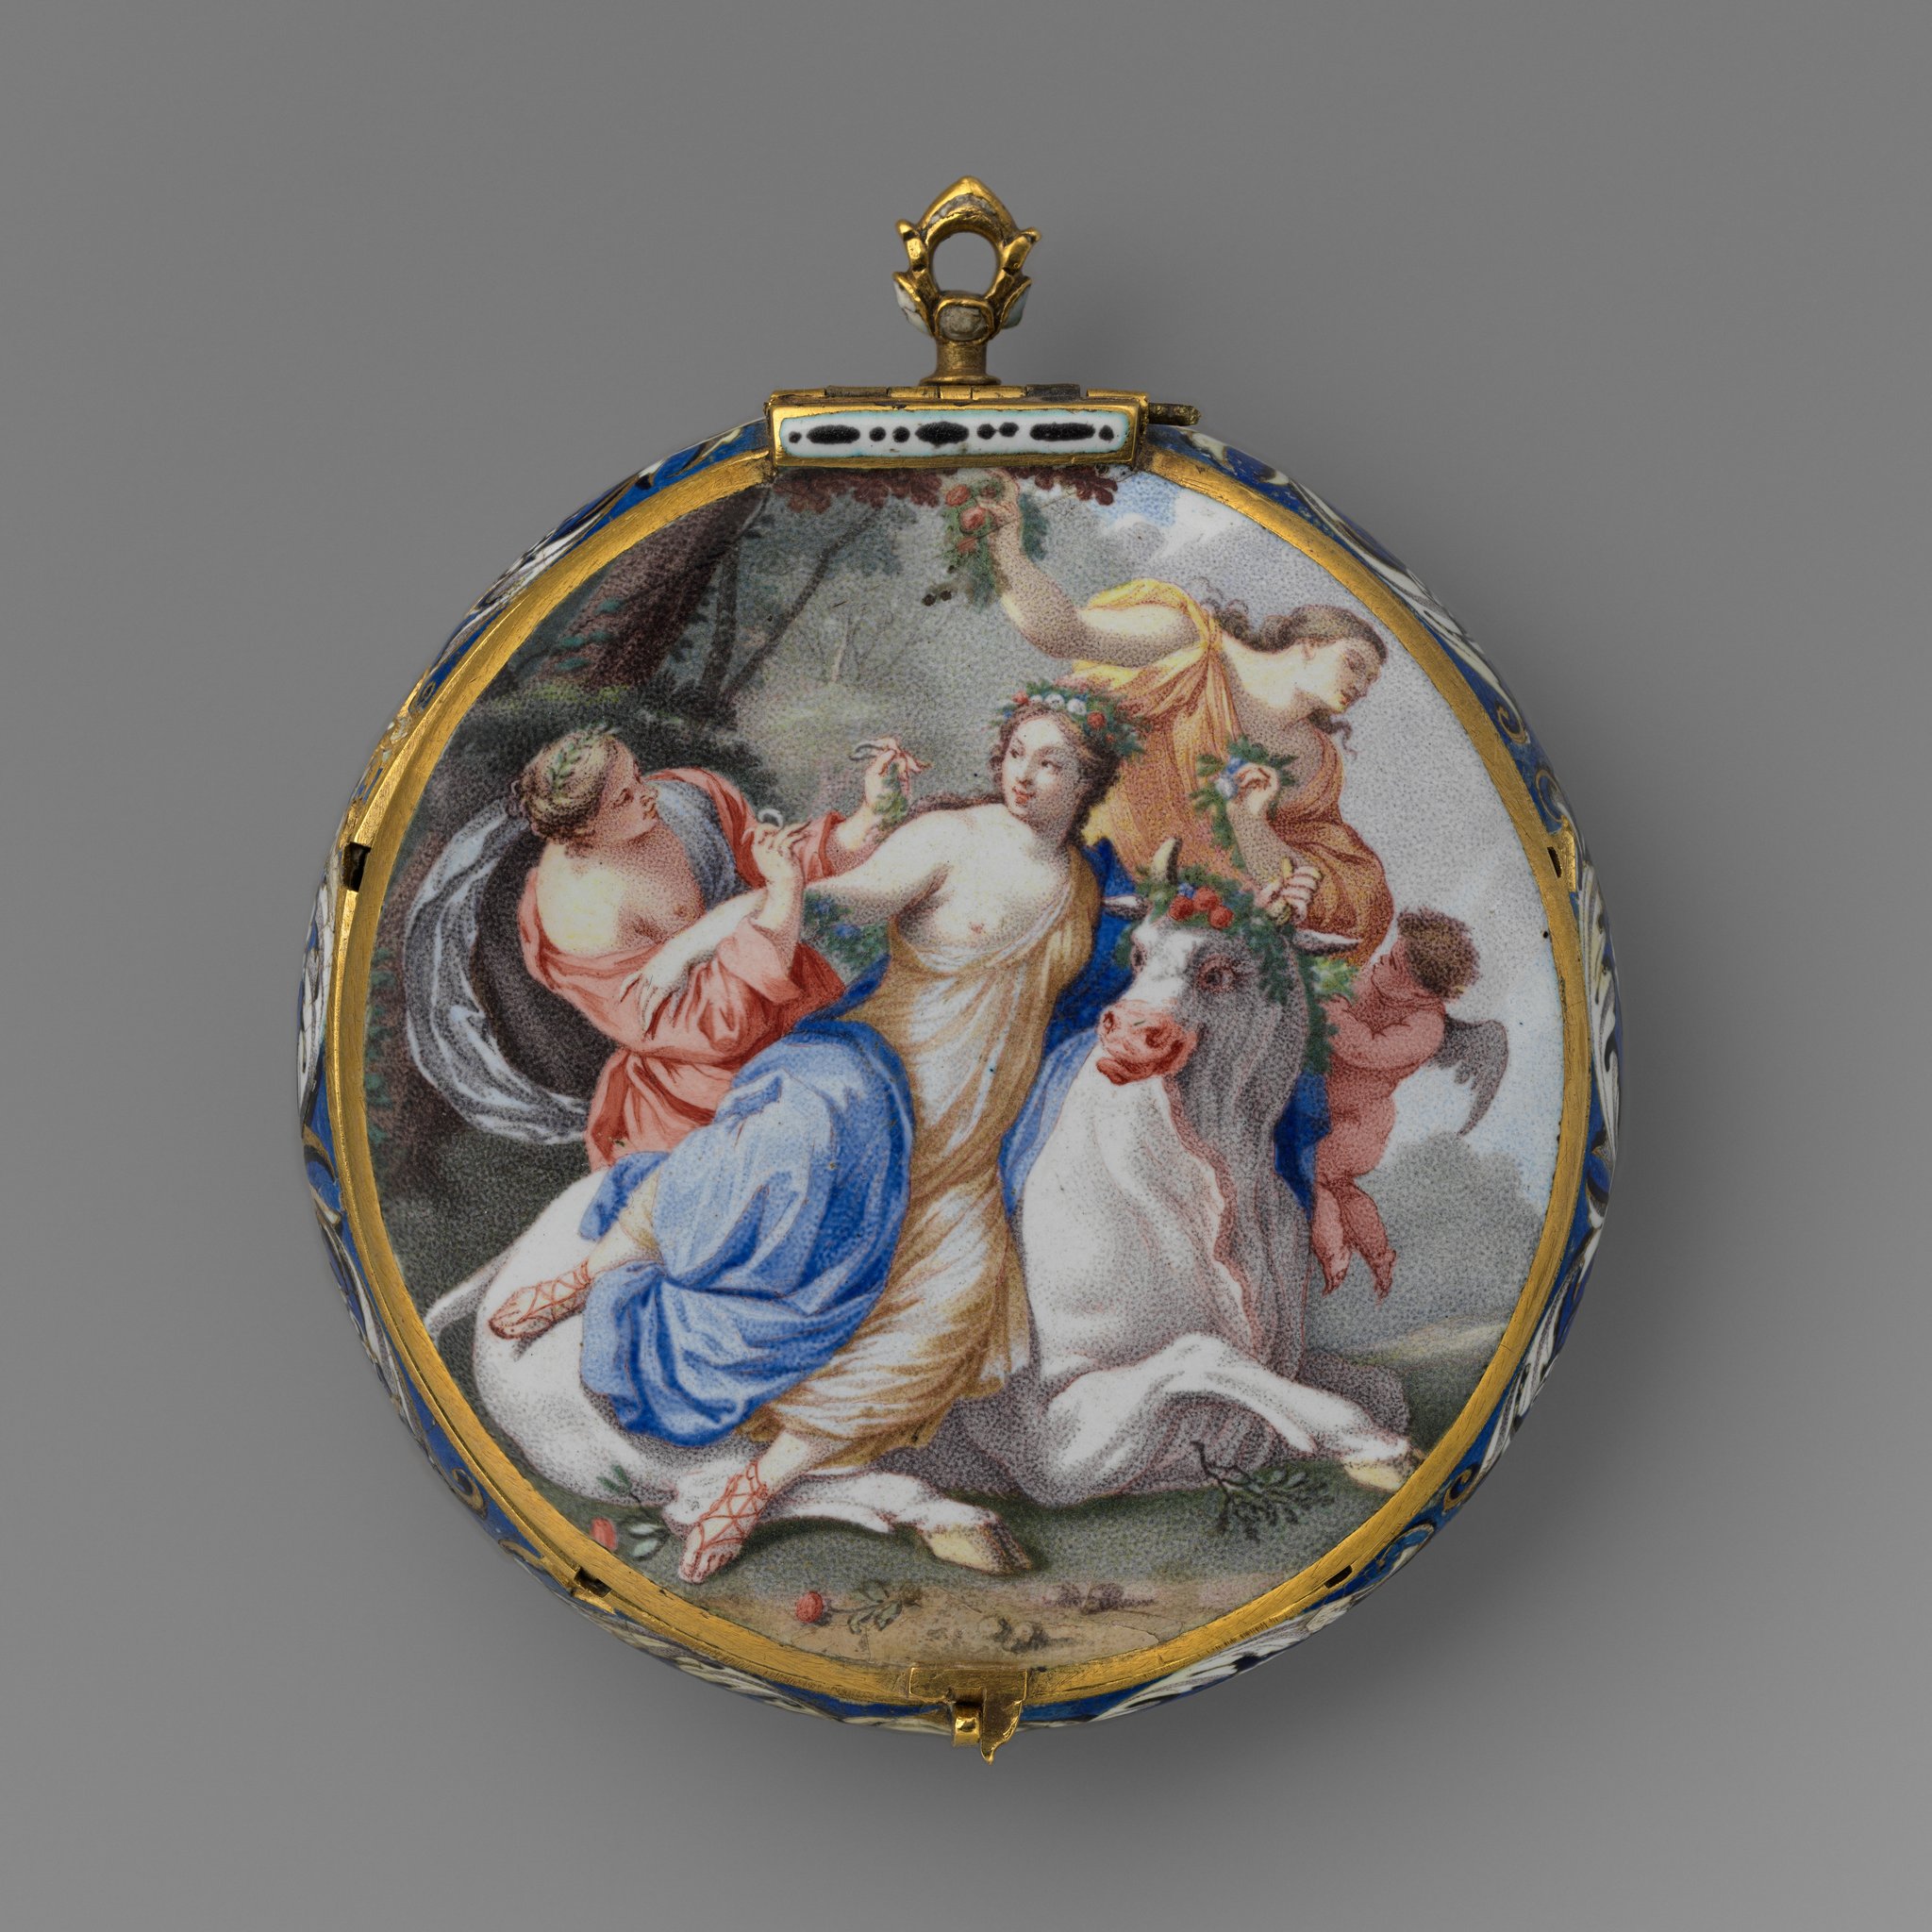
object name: watch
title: The Rape of Europa and Mercury and the Three Graces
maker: lambertus vrythoff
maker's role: maker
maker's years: 1724-1769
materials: gilt brass, gold, steel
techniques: enamel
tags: men,portraits,europa,mercury,horses